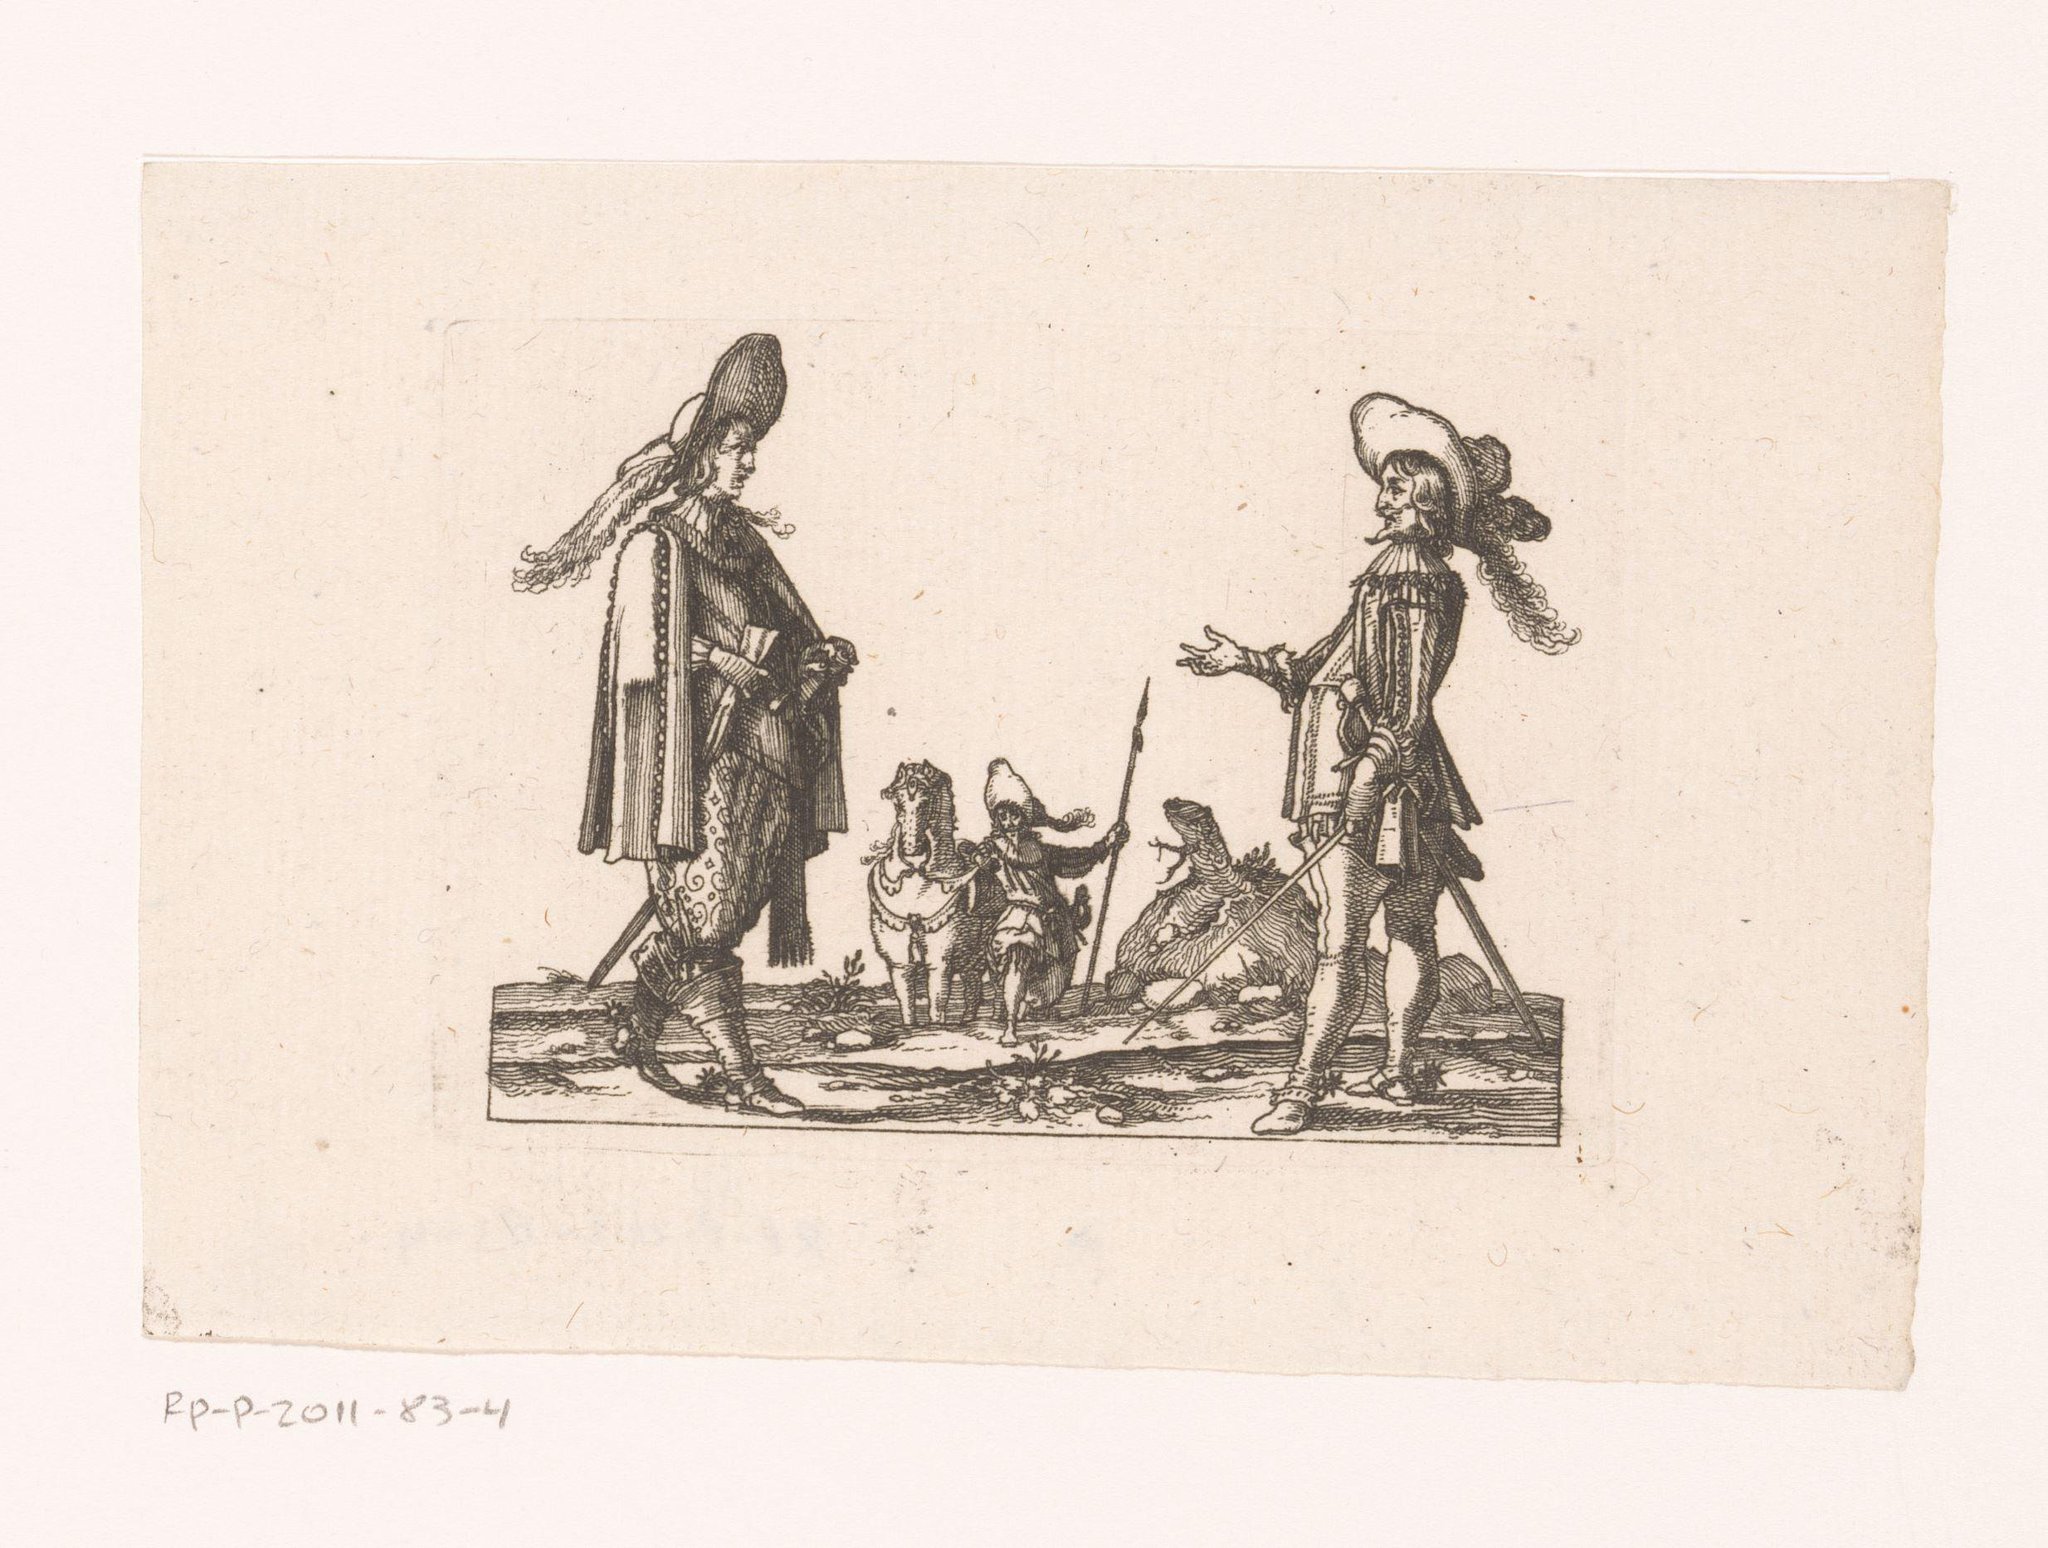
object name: print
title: Soldaten en edelmannen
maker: rudolph meyer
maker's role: print maker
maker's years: 1605-1638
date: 1615-1638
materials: paper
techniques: etching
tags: the soldier; the soldier's life, leading a horse by the reins; rider beside his horse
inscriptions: collector's mark: Lugt 2233, collector's mark: Lugt 2228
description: Onderdeel van een serie van zestien voorstellingen van soldaten (Soldatenbüchli).